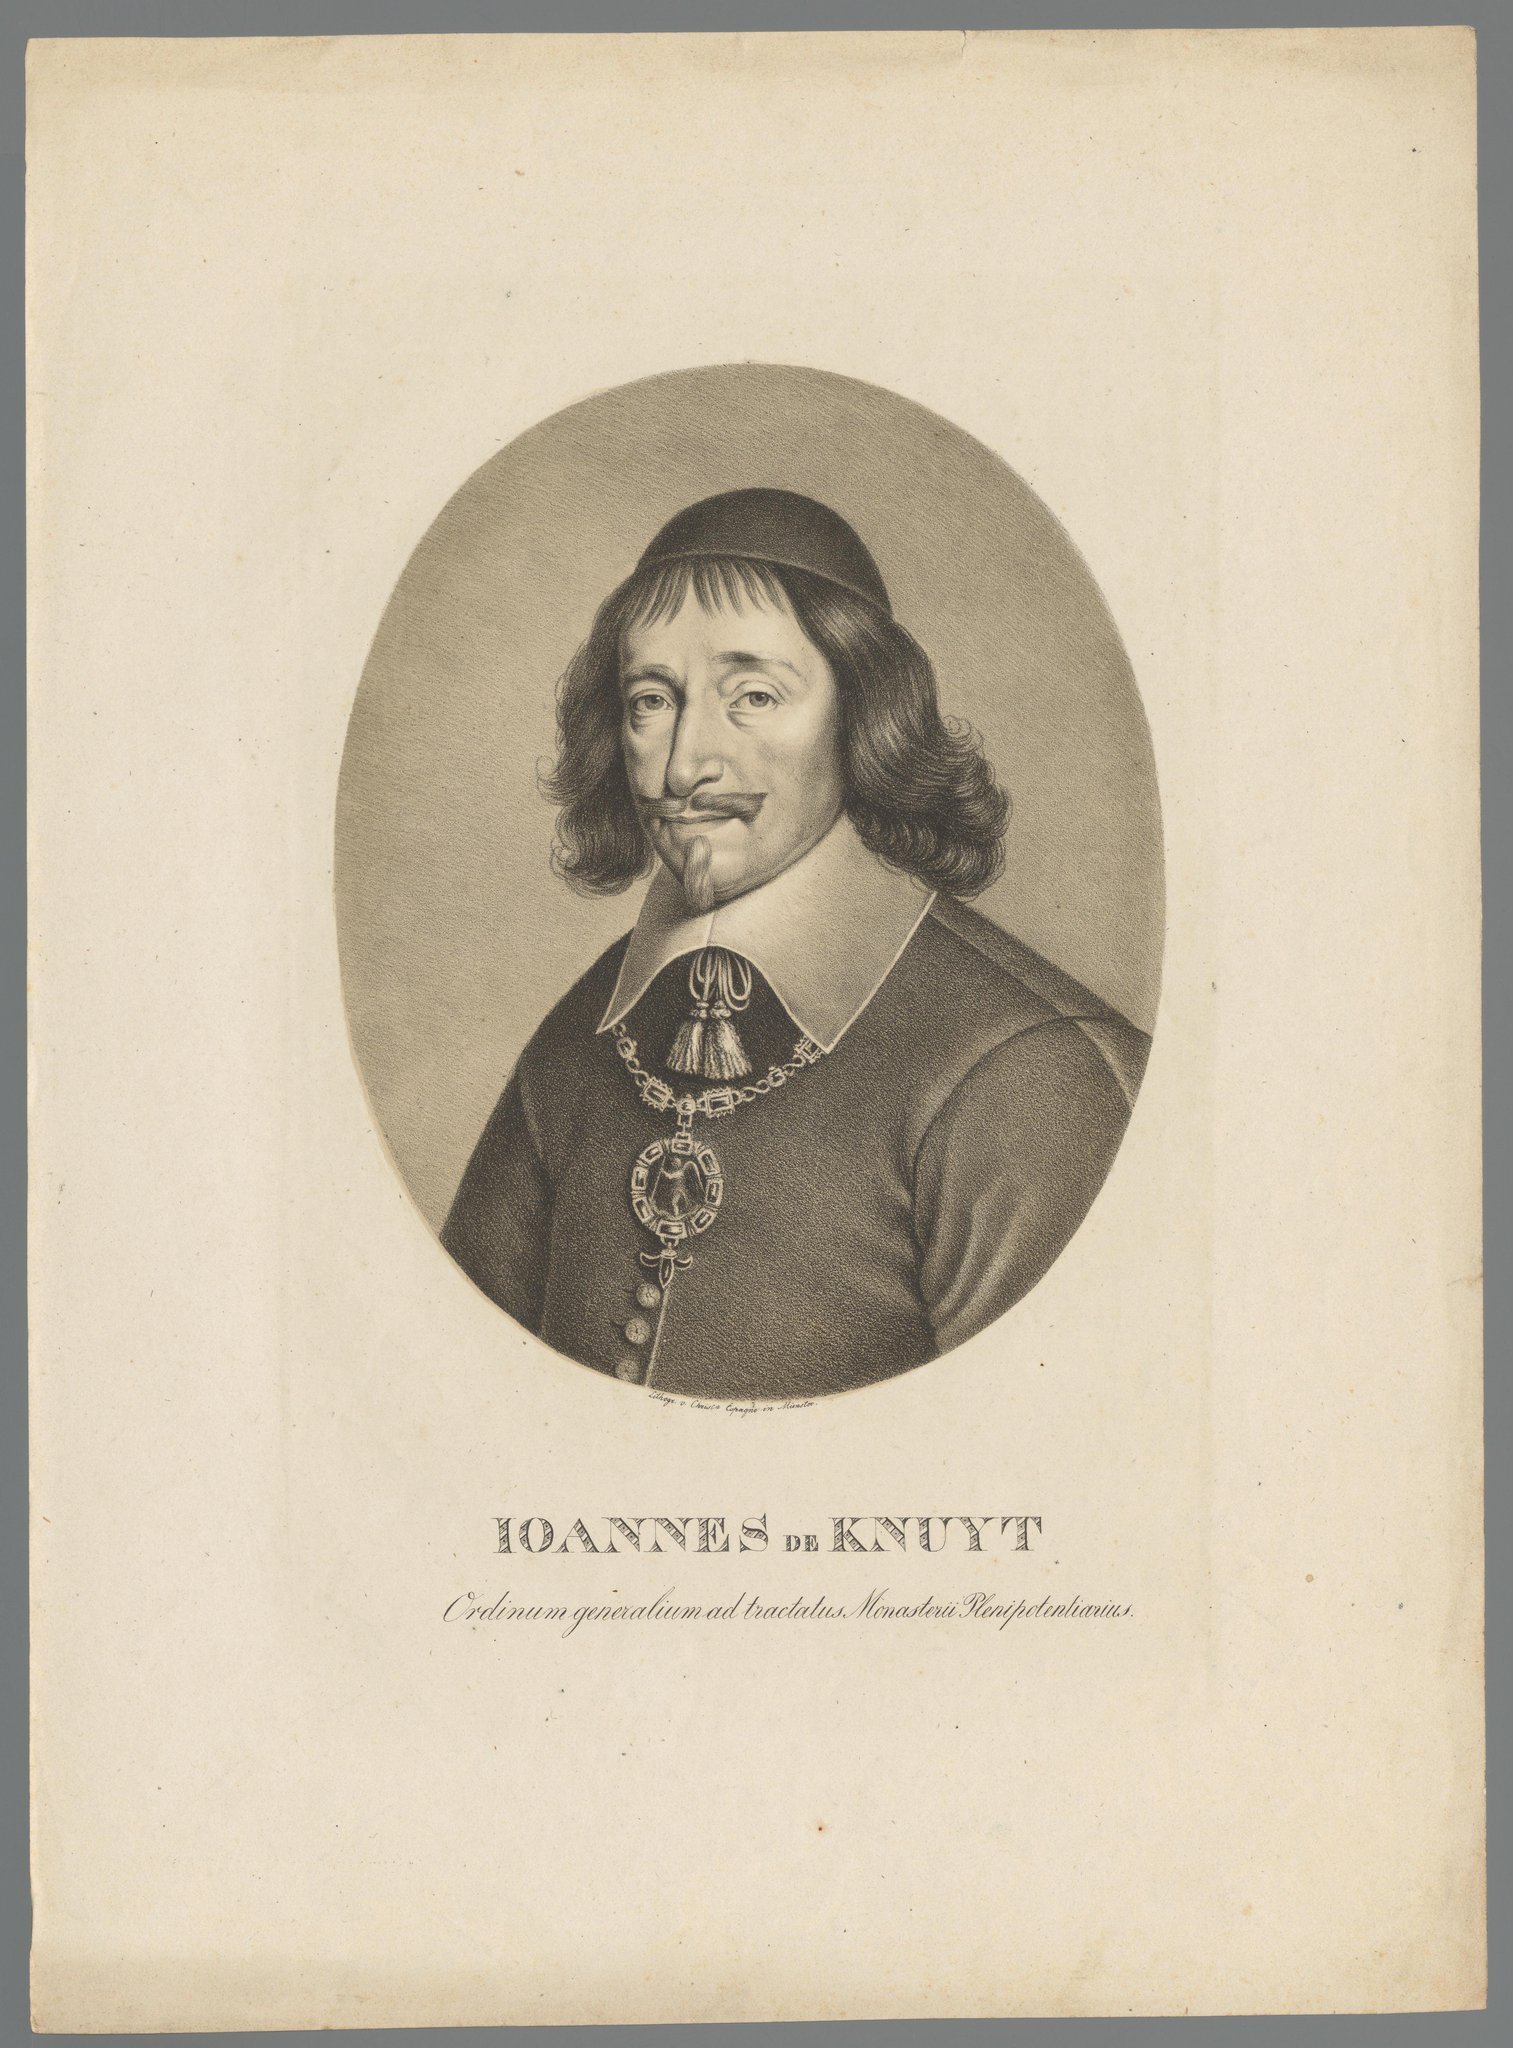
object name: print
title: Joannes de Knuyt, ordinum generalium ad tractatus monasterii plenipotentiarius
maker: christian espagne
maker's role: print maker, printer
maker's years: 1794-1838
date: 1824-1827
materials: paper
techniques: tone lithography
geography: munster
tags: adult man, historical persons, beard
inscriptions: collector's mark: Lugt 2228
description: Prent uit: Bildnisse der beim westfälischen Friedensschluß zu Münster und Osnabrück versammelt gewesenen Gesandten. Münster: Christian Espagne, [1824-1827]. Deze publicatie bevat een onbekend aantal lithografieën, die in afleveringen verschenen als illustratie bij de tekst.